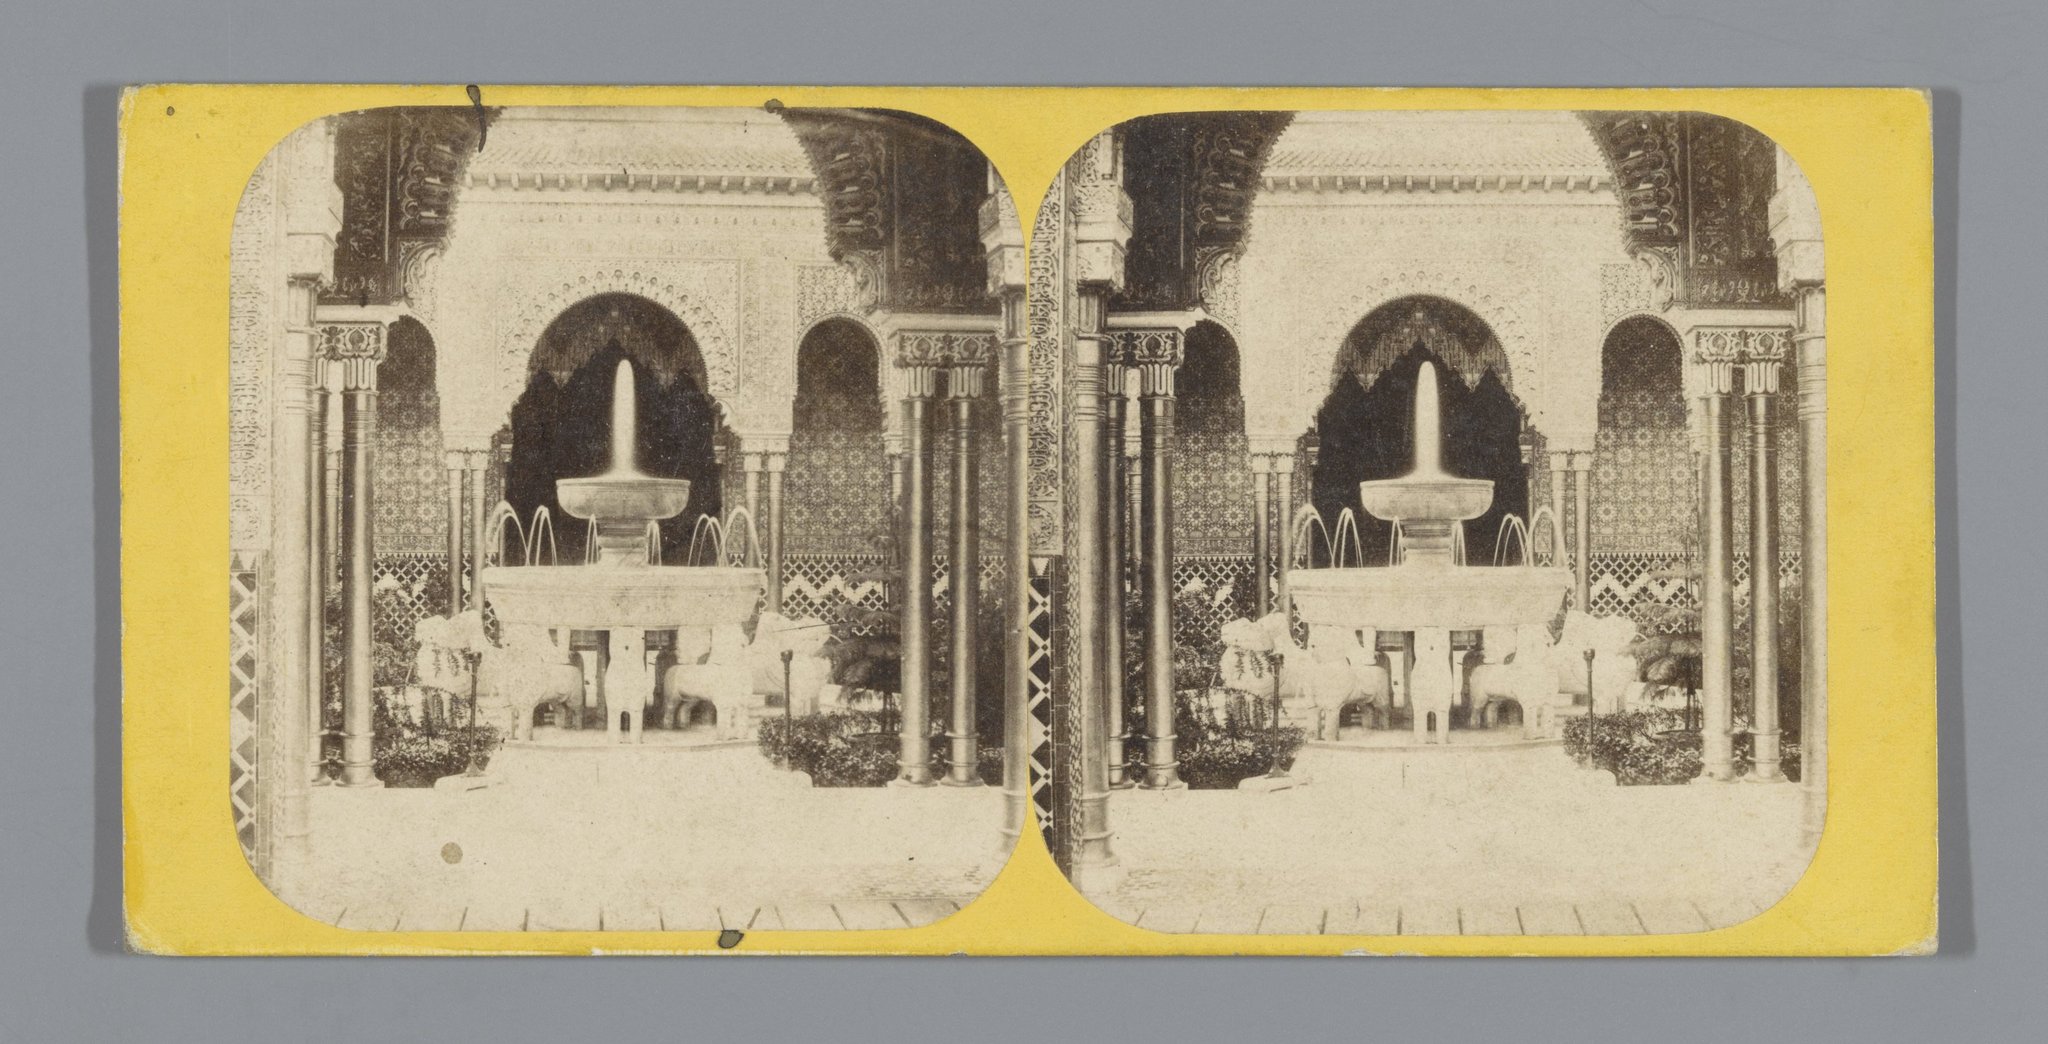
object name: stereograph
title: Alhambra Court in het Crystal Palace in Londen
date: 1854-1886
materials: cardboard, photographic support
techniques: albumen print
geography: crystal palace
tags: ornamental fountain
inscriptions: number: ‘60.’